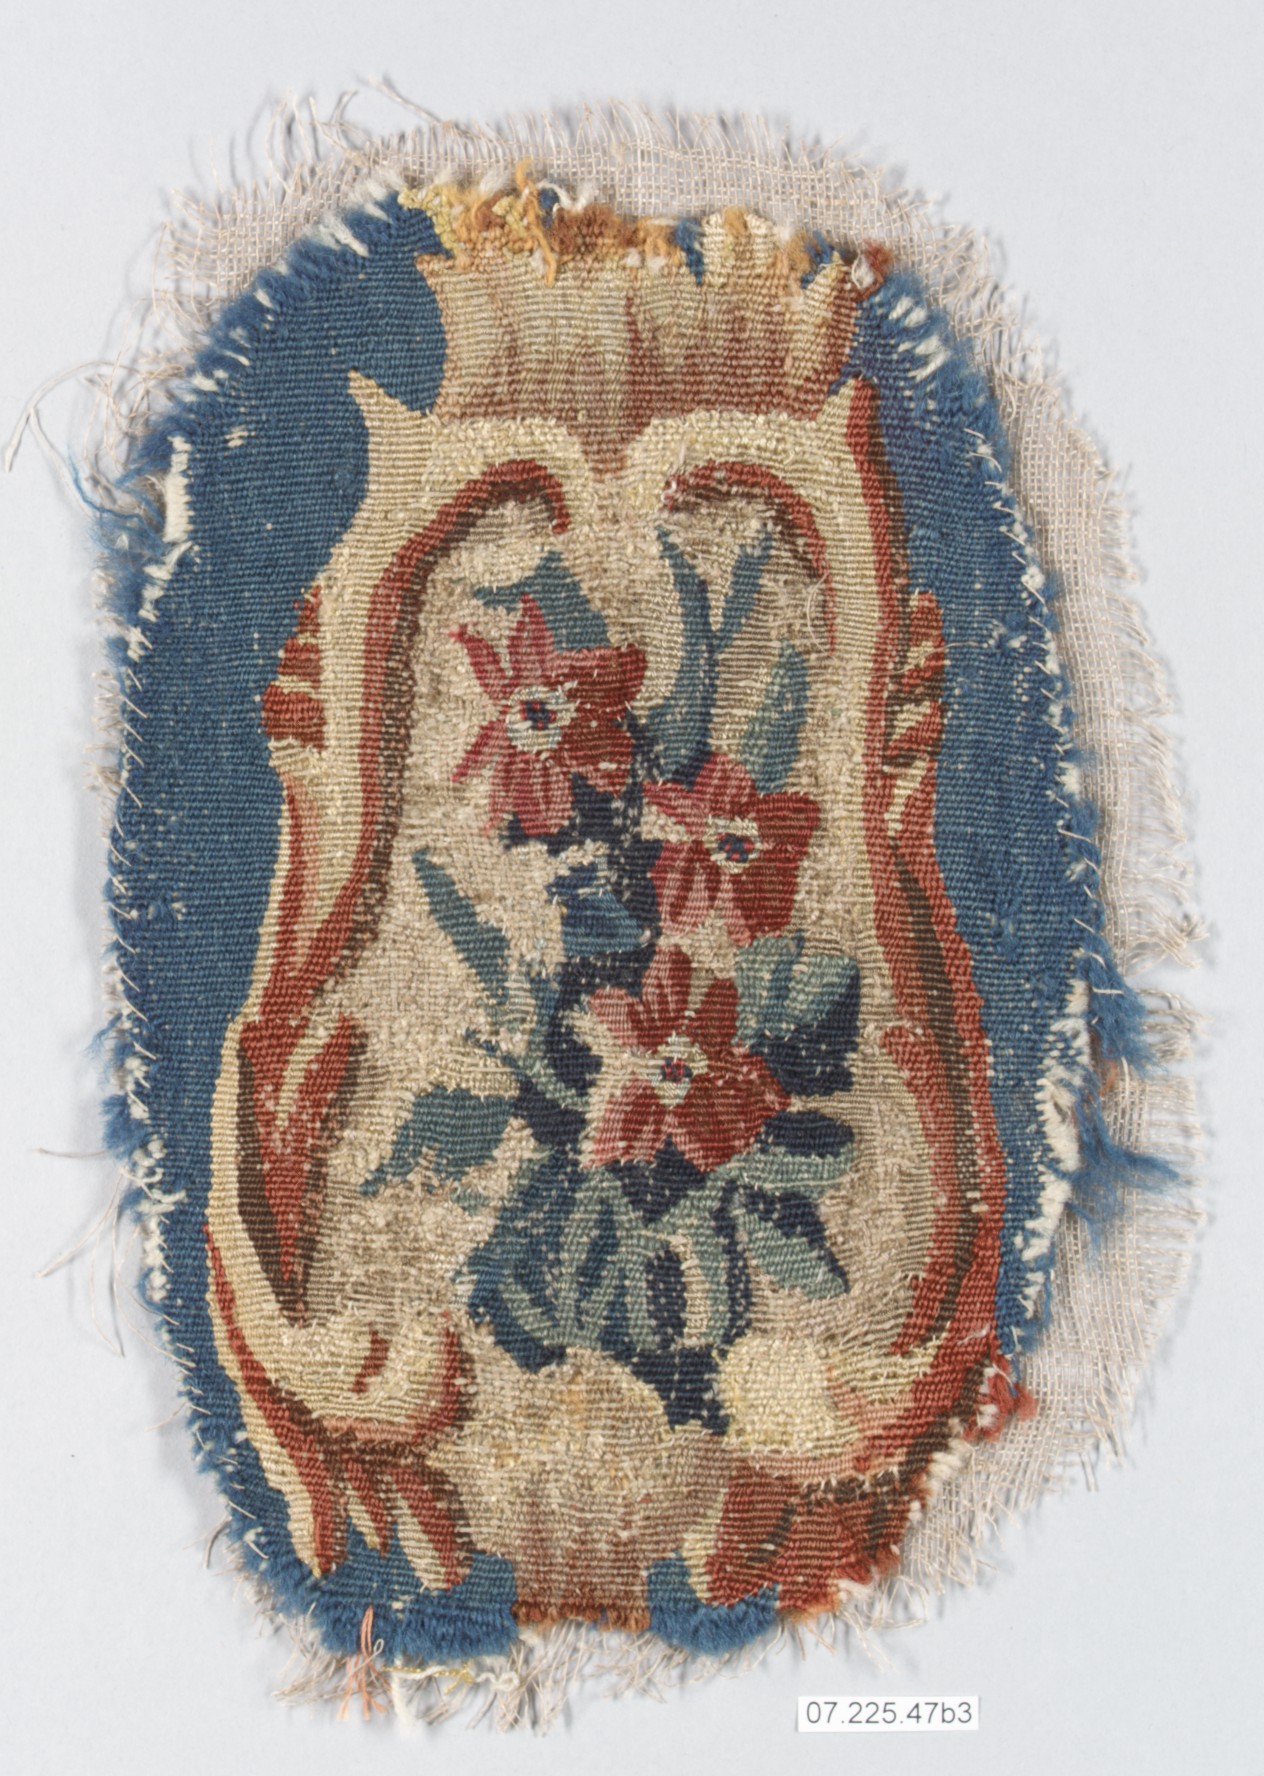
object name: upholstery panel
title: Rocaille cartouche with flowers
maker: beauvais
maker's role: manufactory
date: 1735-1750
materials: silk, wool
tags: flowers